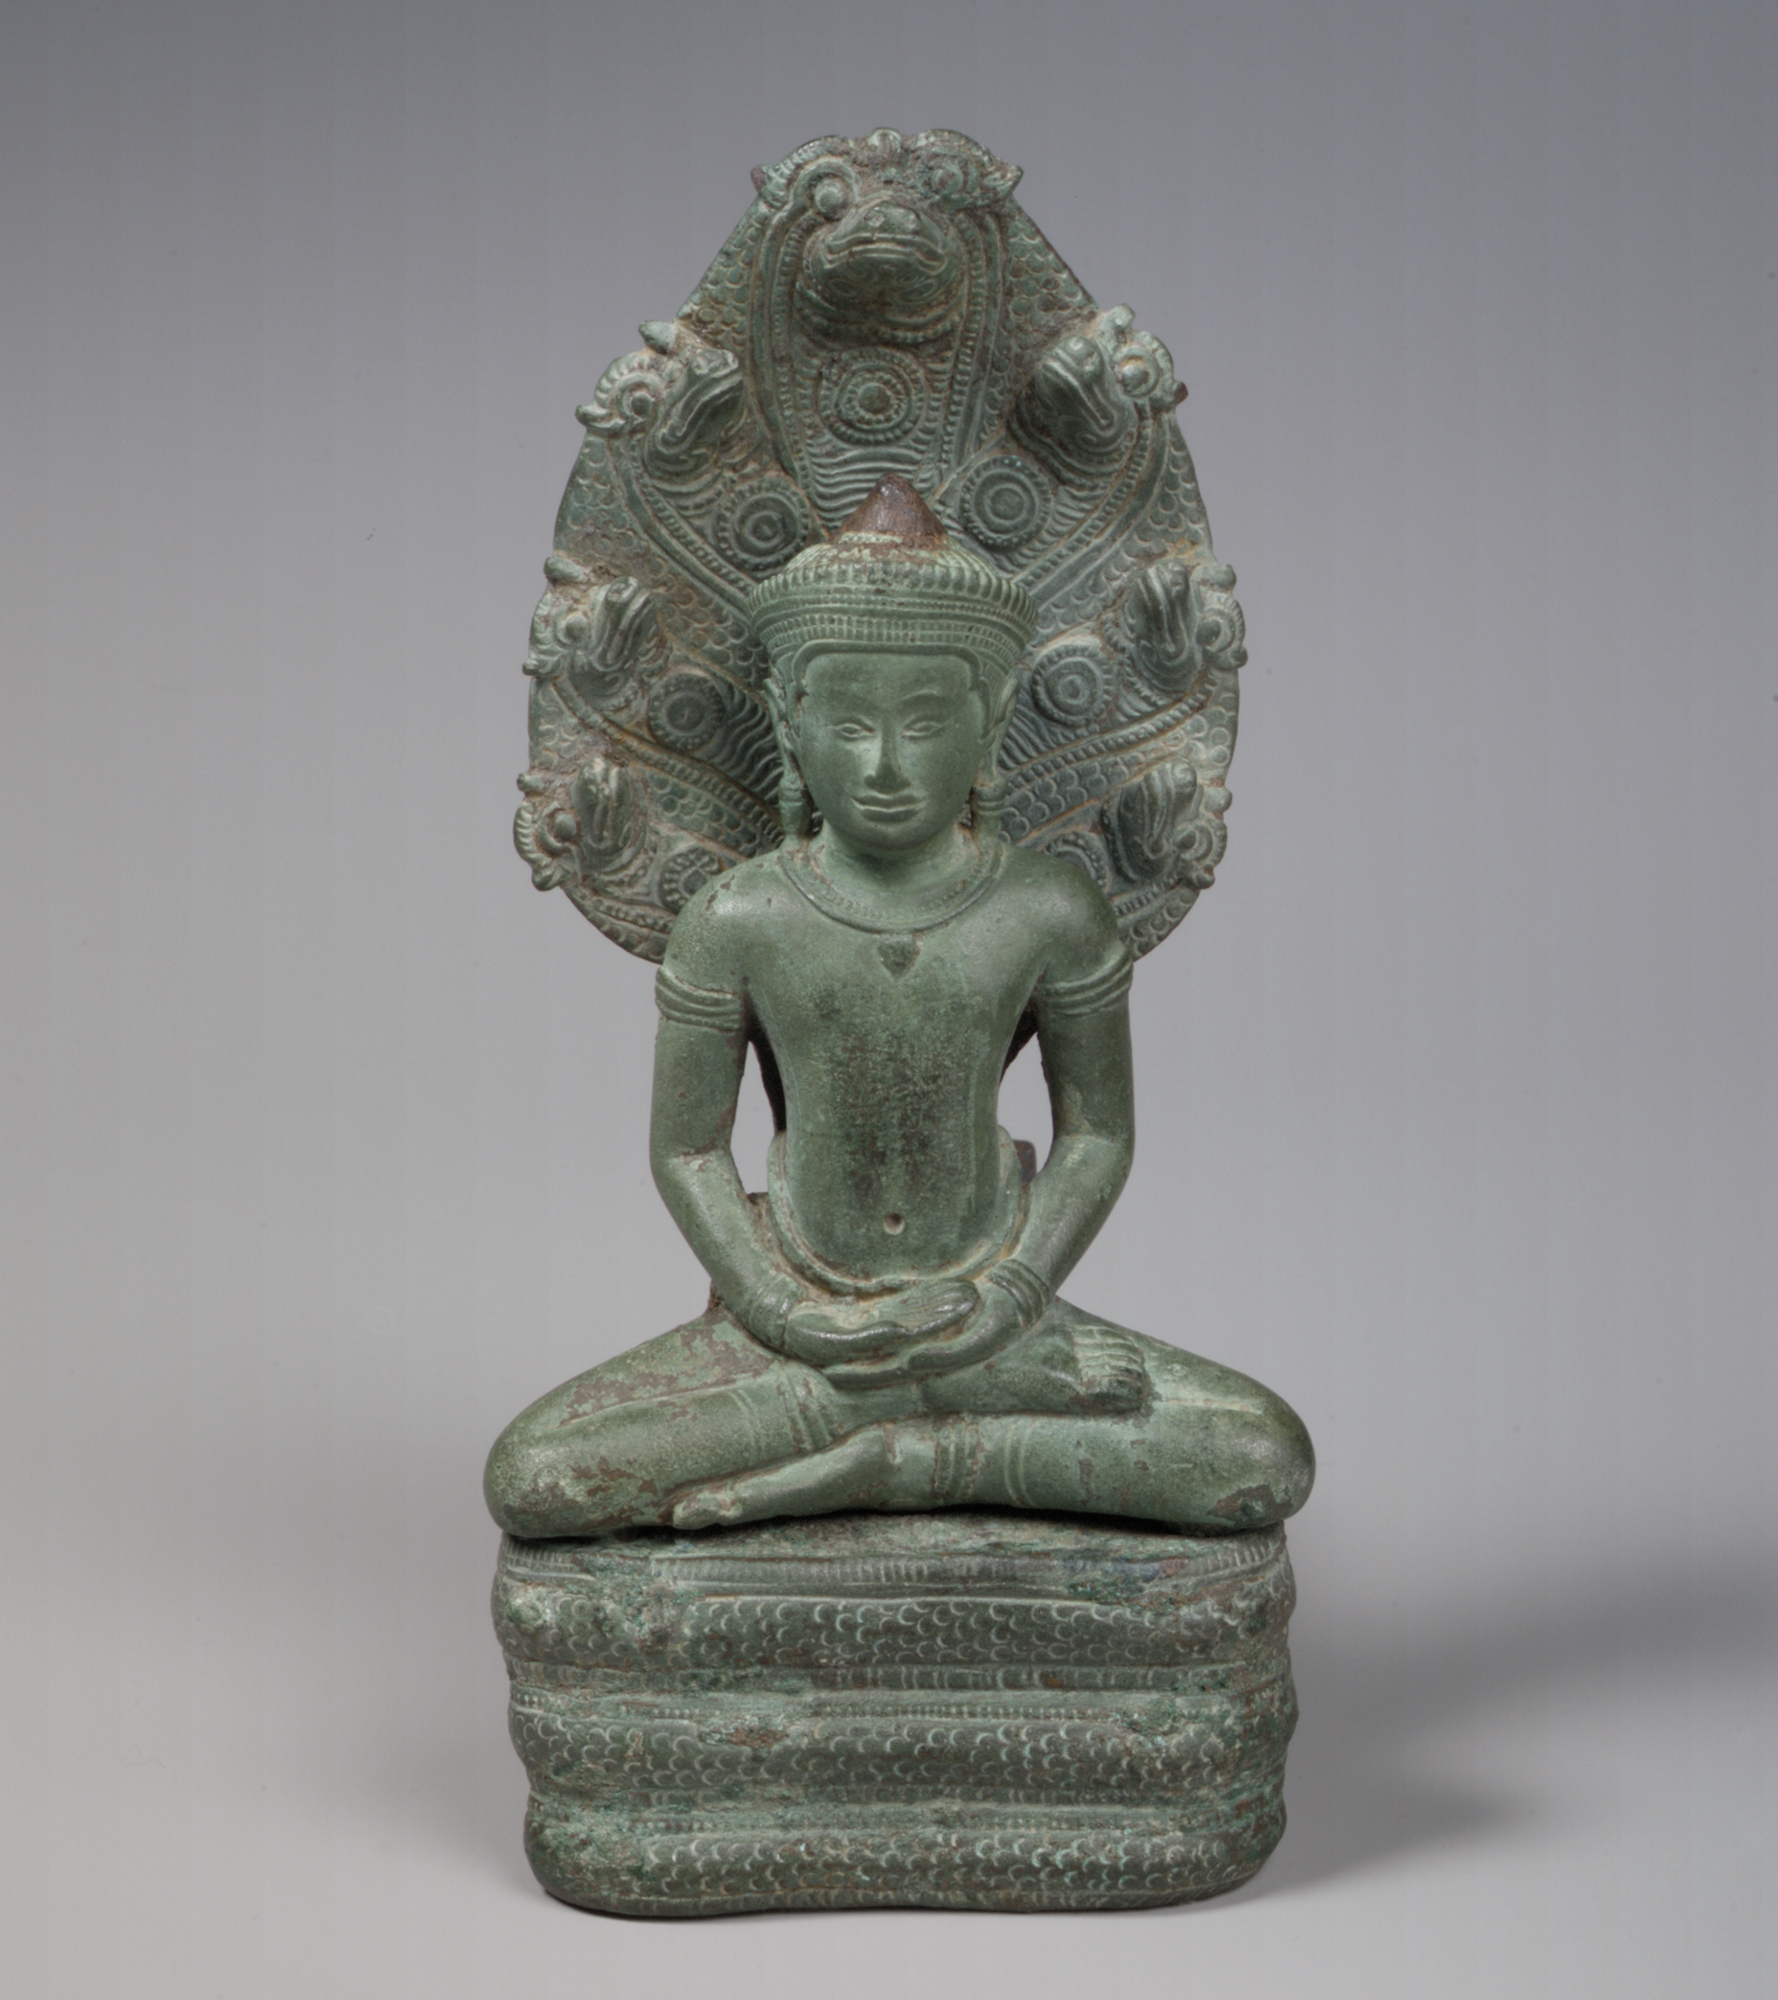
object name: figure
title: Buddha Sheltered by a Naga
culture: cambodian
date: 1101-1200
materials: bronze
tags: serpents,buddhism,buddha